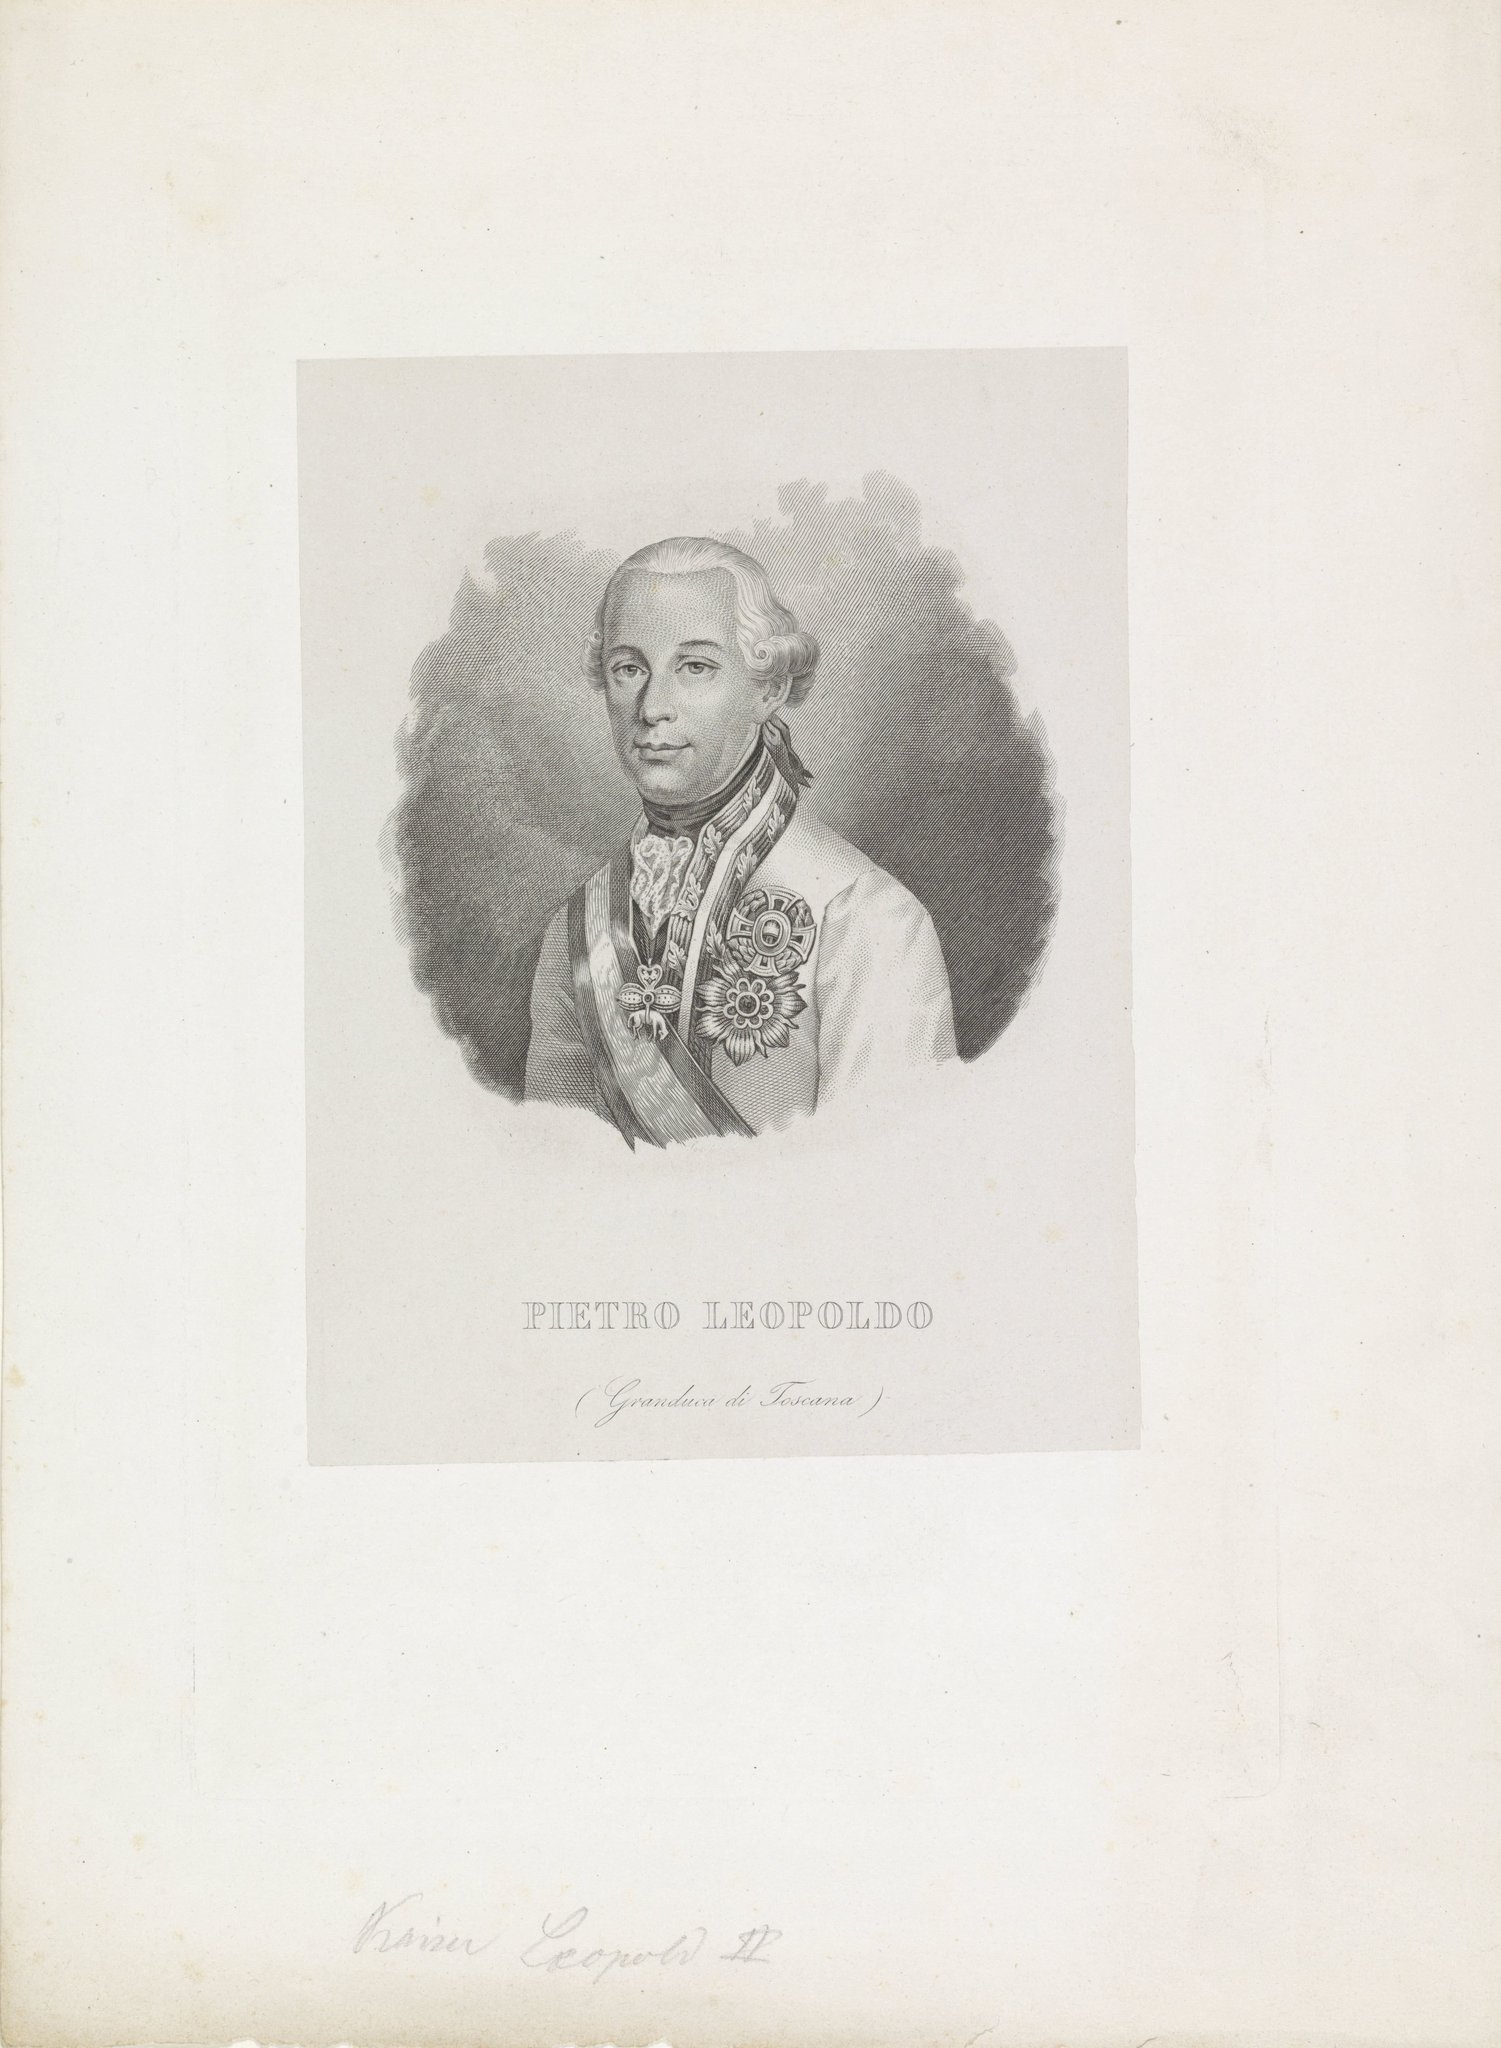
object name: print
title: Portret van Keizer Leopold II van Duitsland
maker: gaetano bonatti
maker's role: print maker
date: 1845-1855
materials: paper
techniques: engraving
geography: italy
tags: vienna, leopold ii (keizer van oostenrijk), historical persons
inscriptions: collector's mark: Lugt 2228